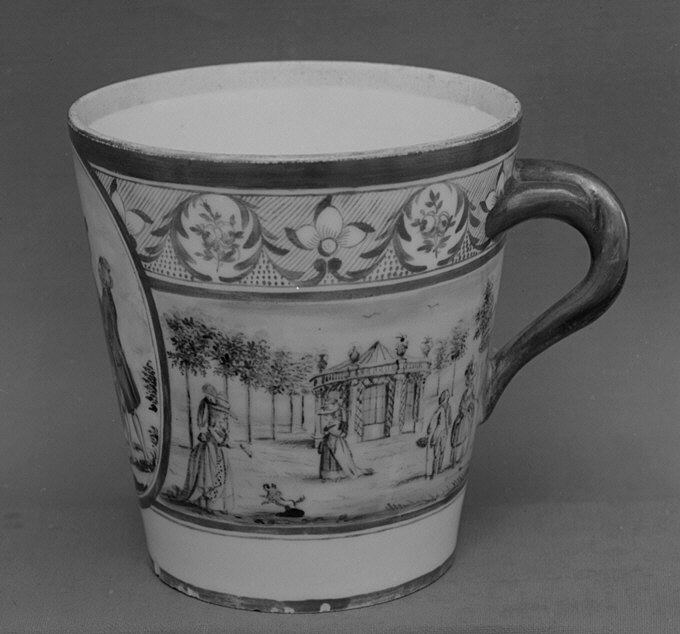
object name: cup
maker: la courtille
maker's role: factory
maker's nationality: french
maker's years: 1771-1840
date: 1767-1800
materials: hard paste porcelain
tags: men,women,dogs